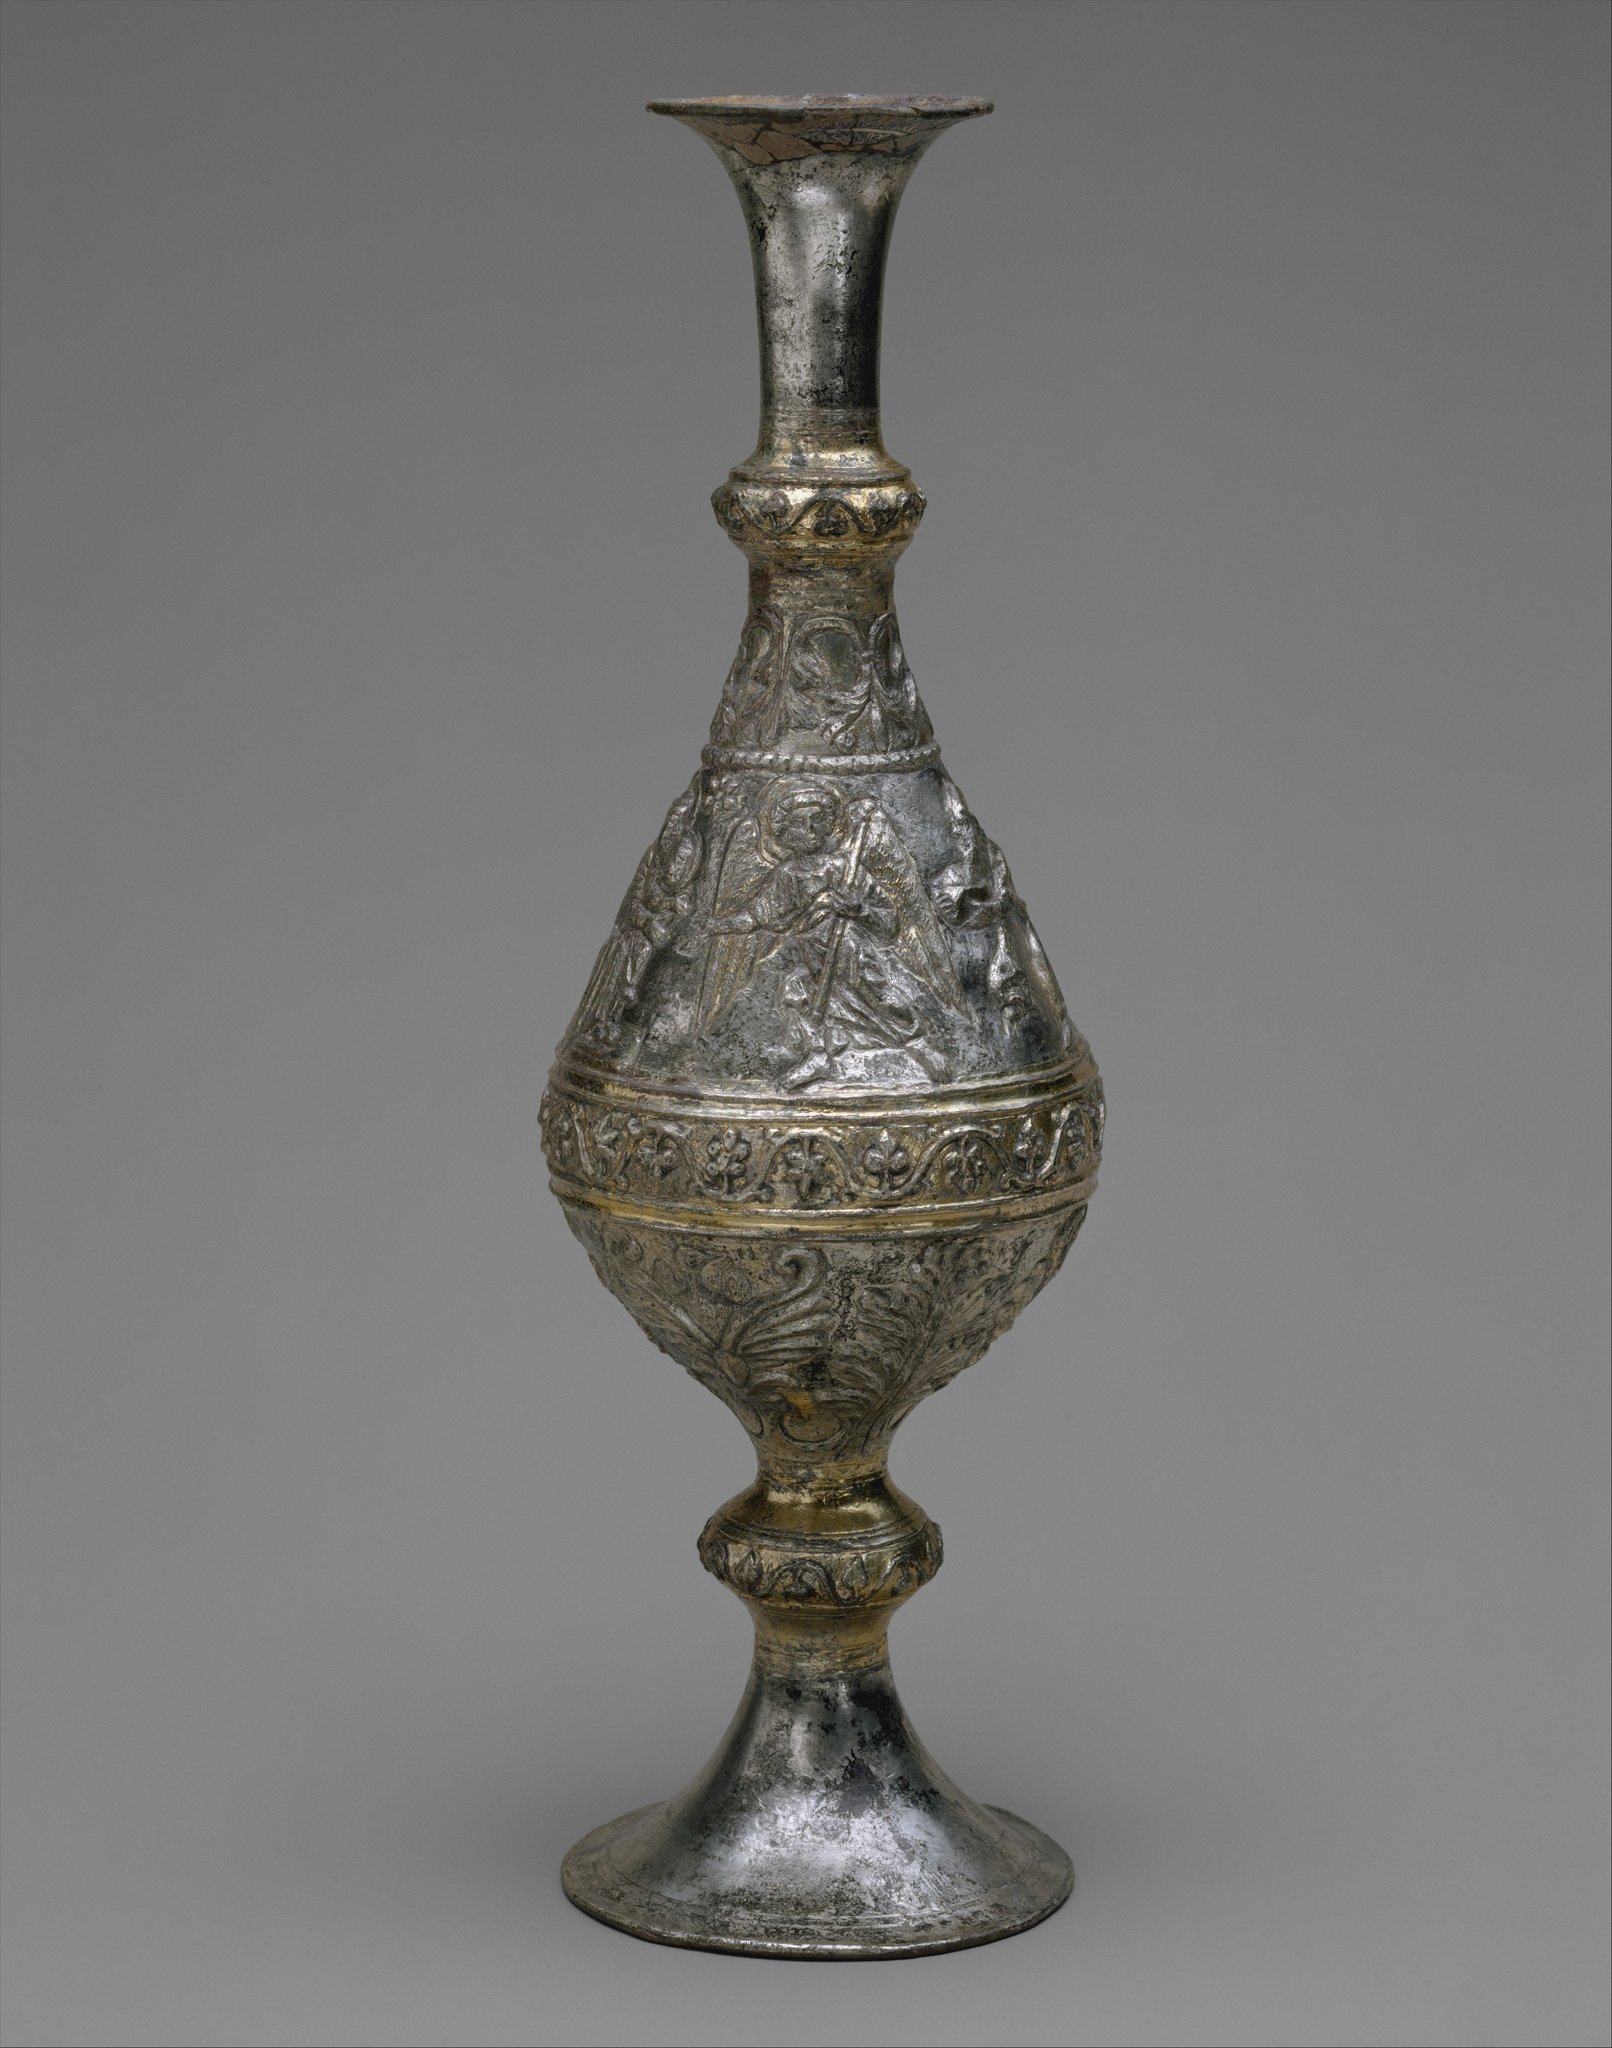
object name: flask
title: Flask with the Adoration of the Magi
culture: byzantine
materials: silver, silver gilt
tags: adoration of the magi